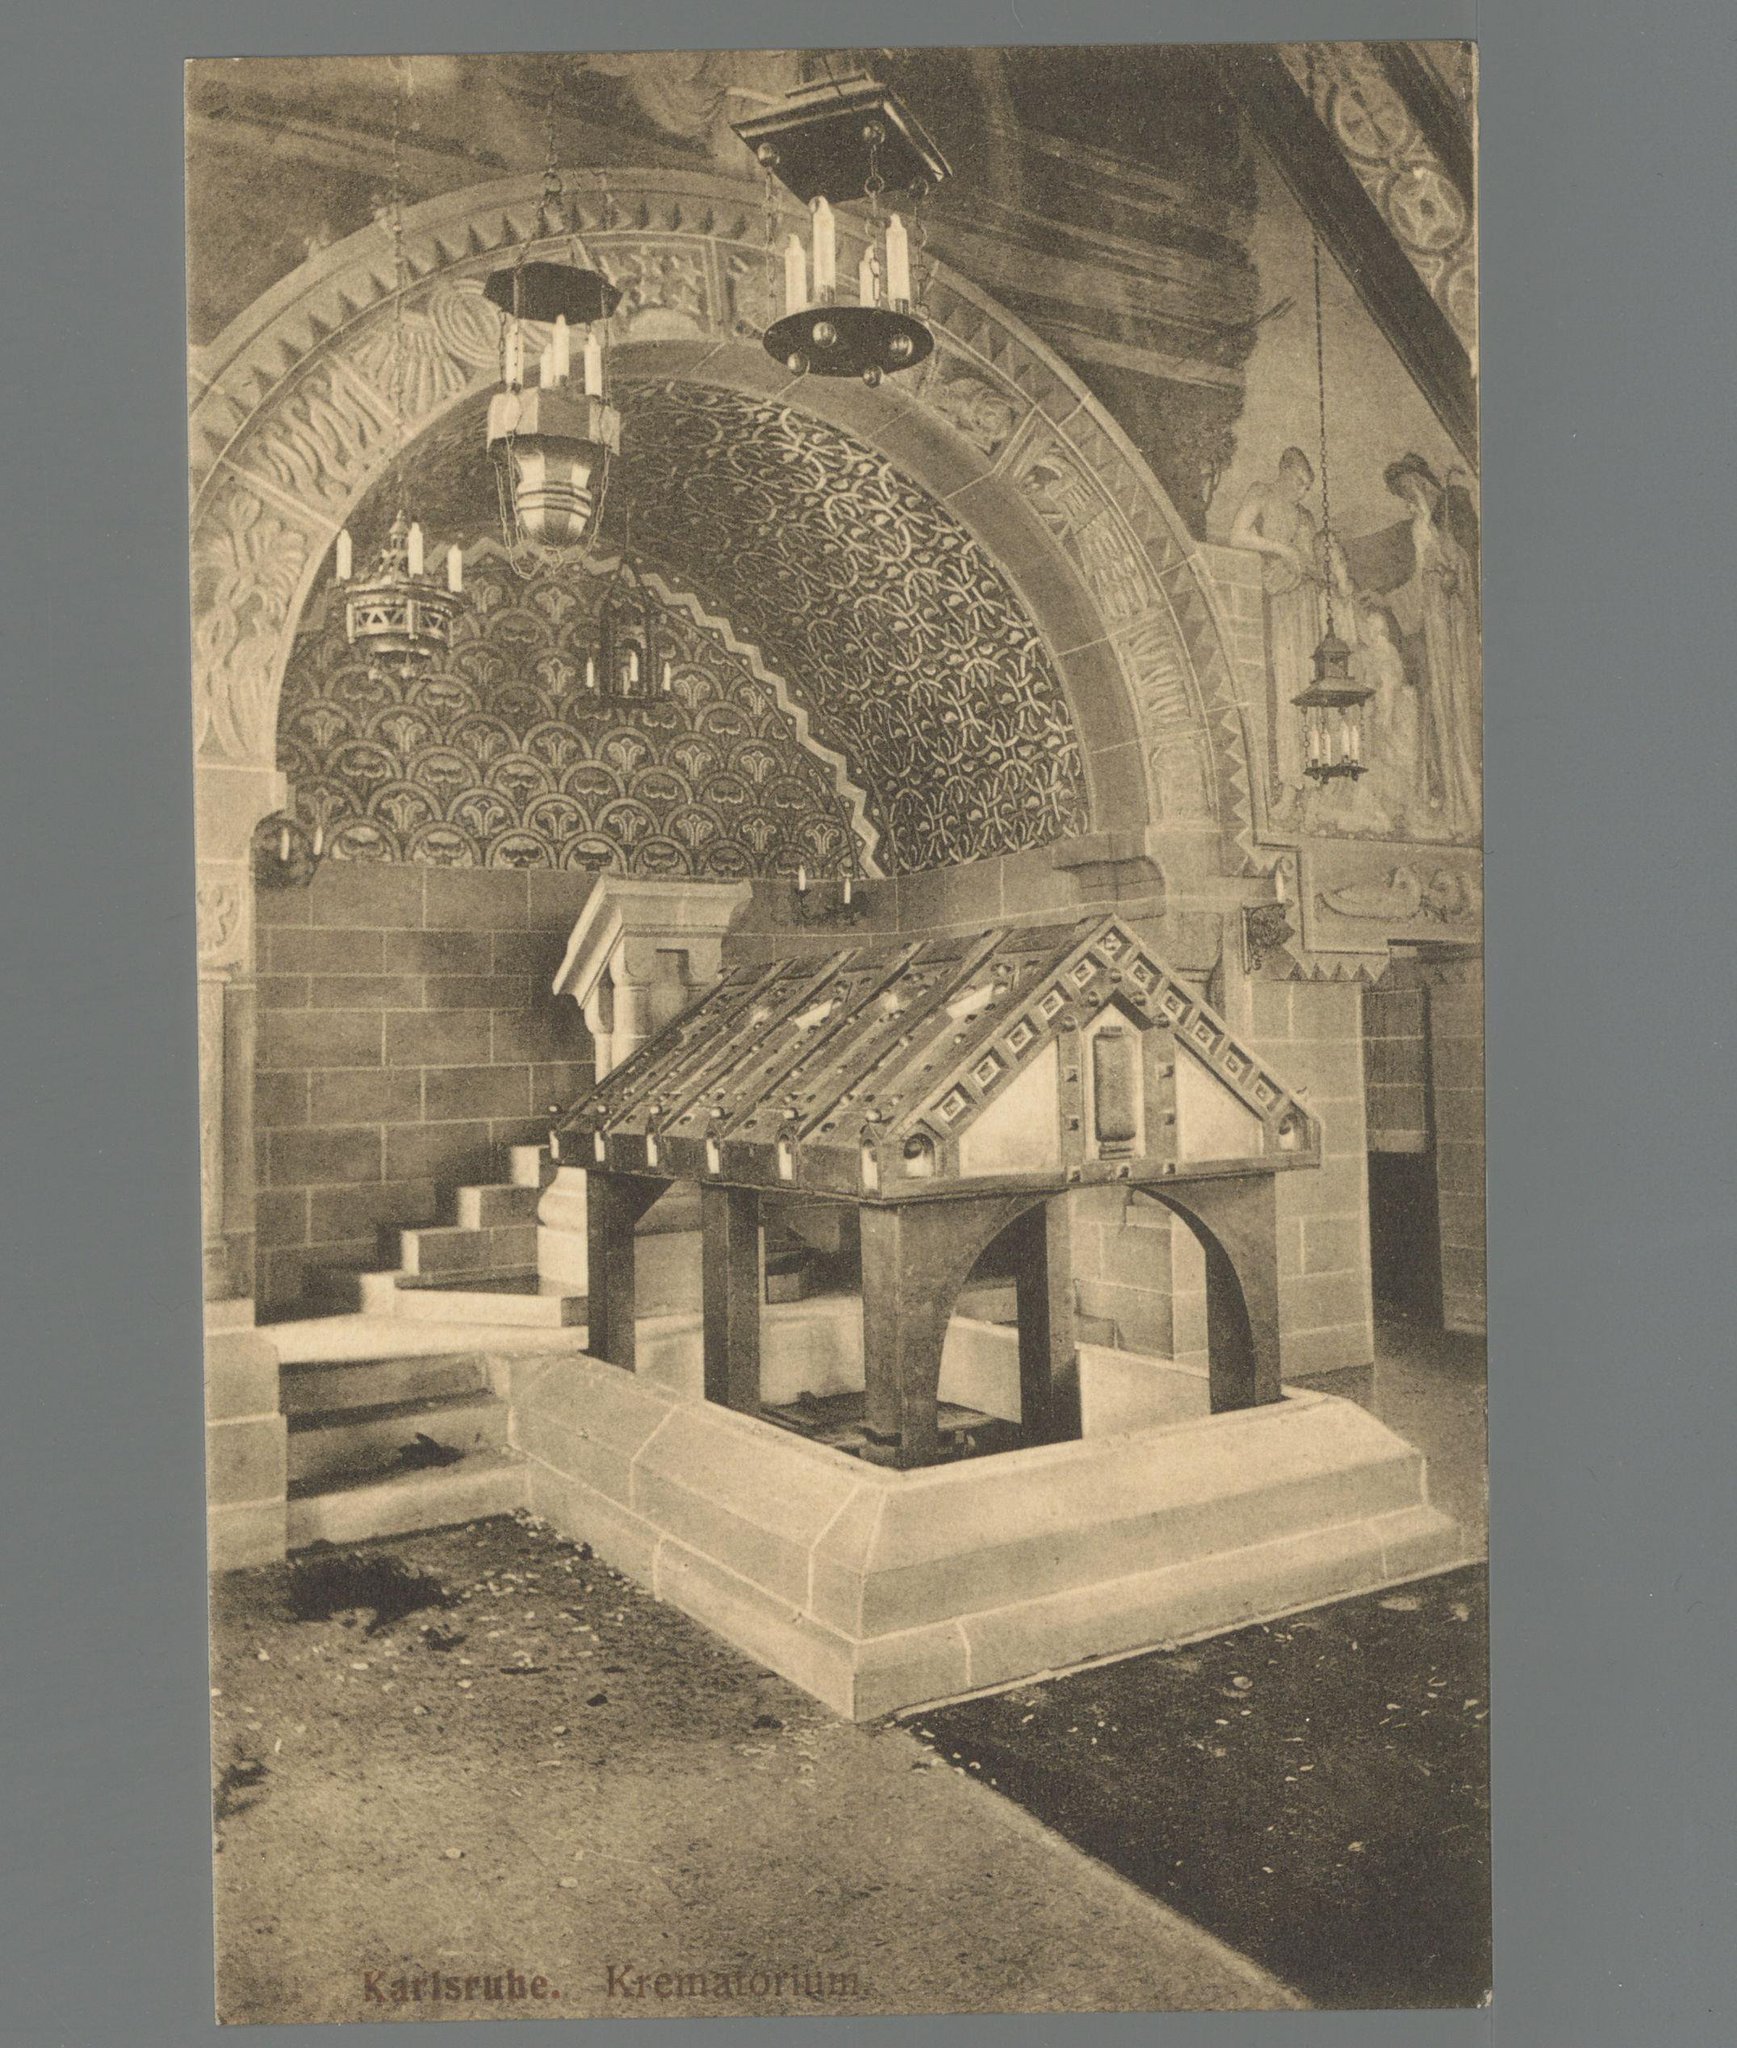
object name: ansichtkaart, prentbriefkaart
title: Karlsruhe. Krematorium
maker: Anonymous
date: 1905-1906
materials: cardboard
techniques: photograph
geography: karlsruhe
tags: body-burning, cremation